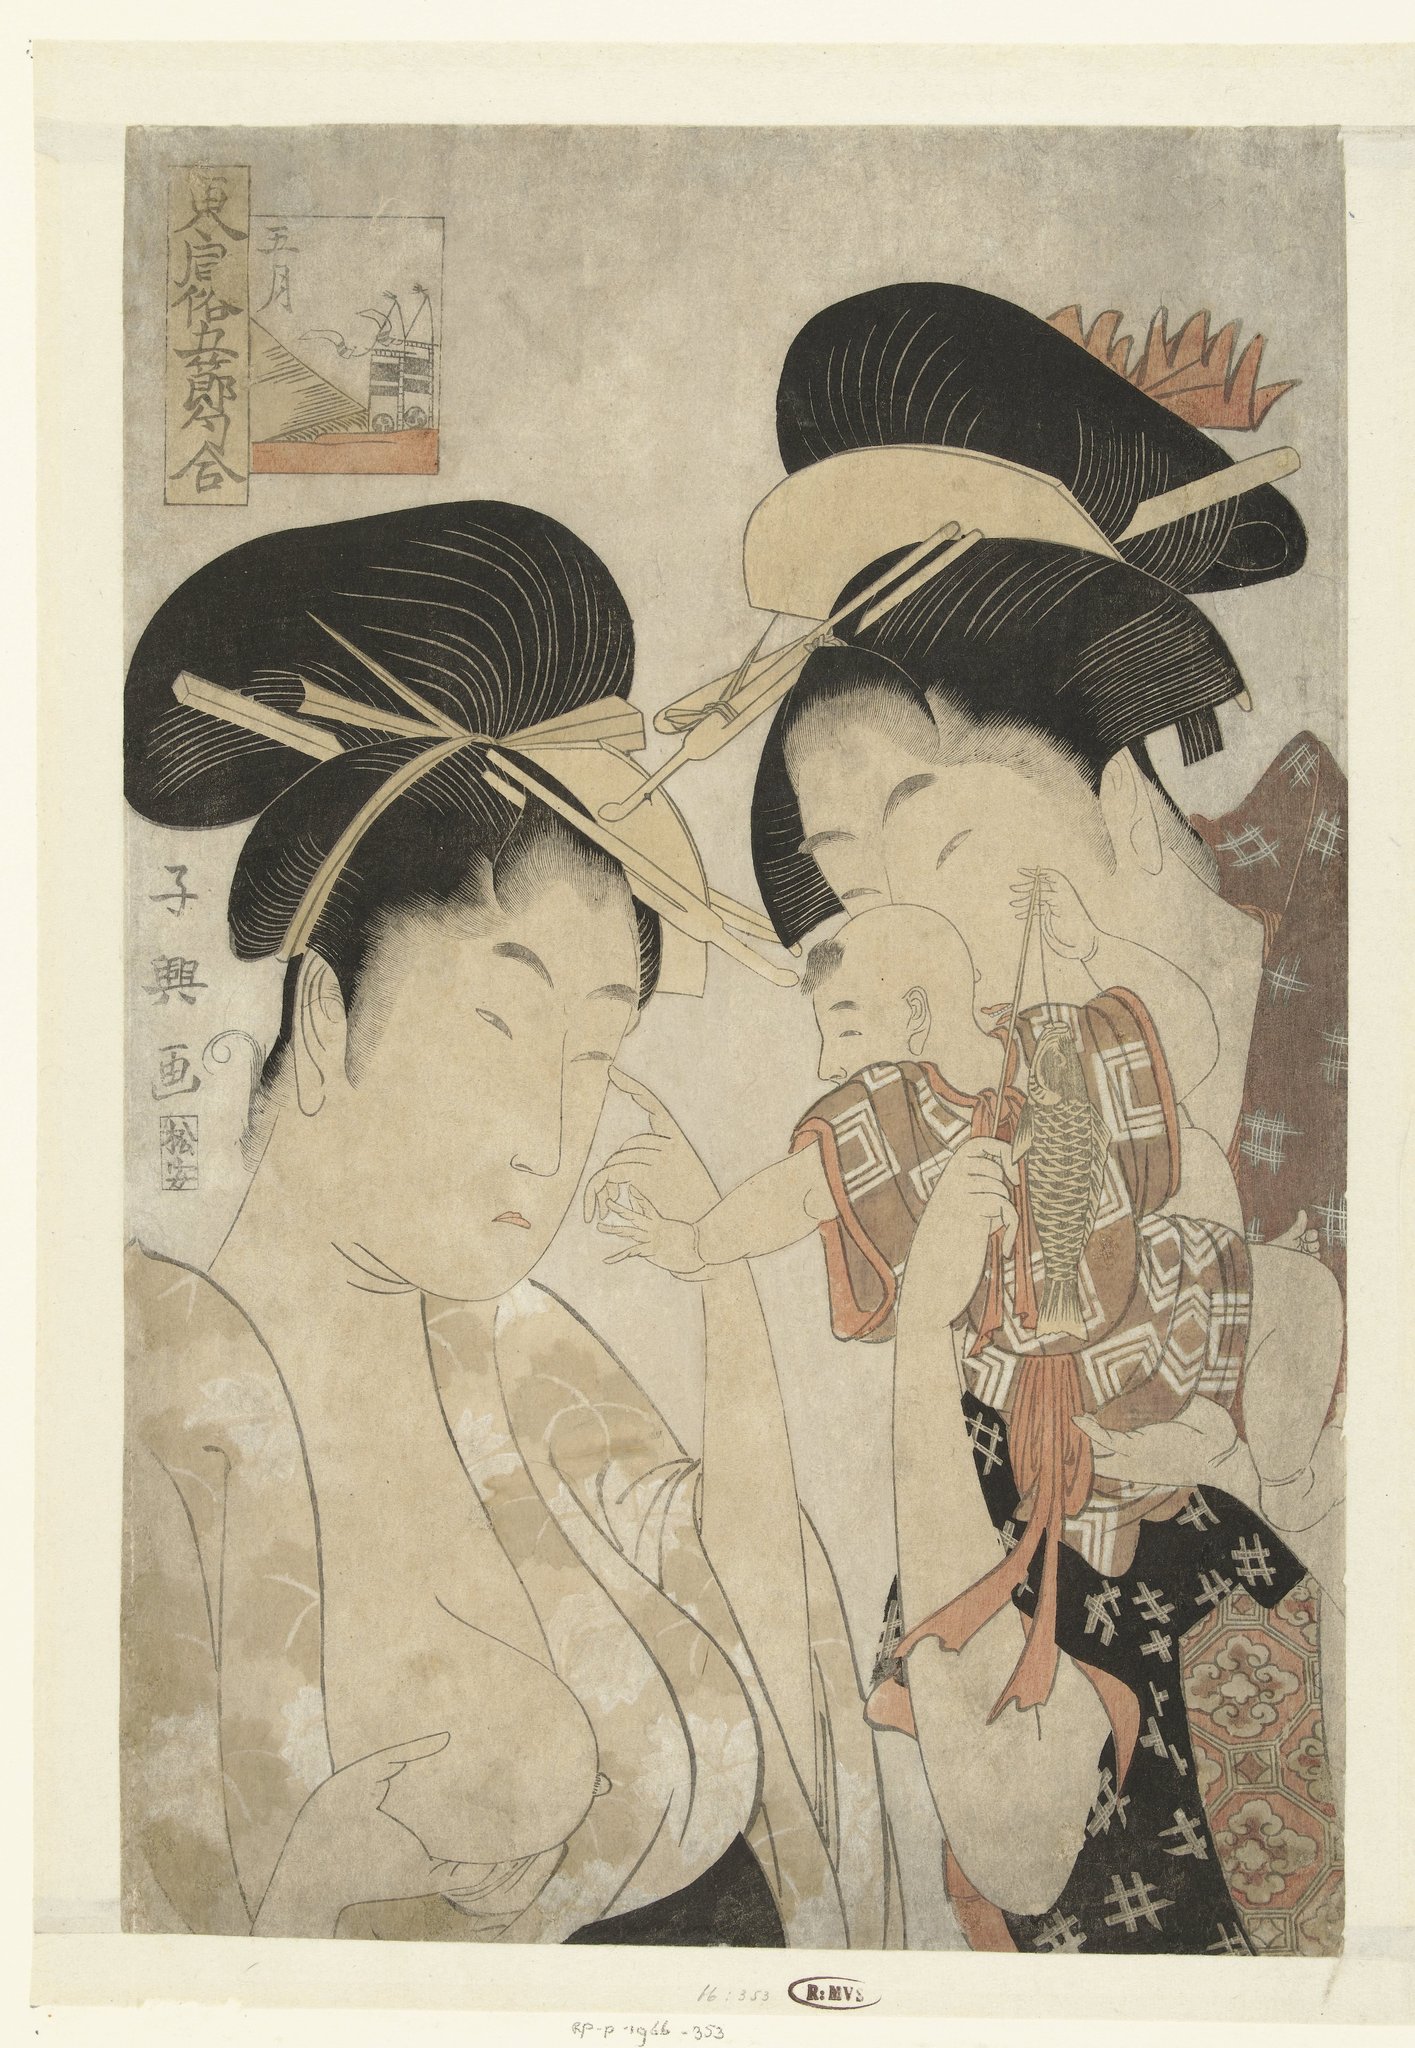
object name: print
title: Twee vrouwen en een klein kind: de vijfde maand.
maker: momokawa chôki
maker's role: print maker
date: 1800-1809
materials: paper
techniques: woodcut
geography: japan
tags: partially clothed, feeding a baby, adult woman (+ front view)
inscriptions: collector's mark: Lugt 2228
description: Vrouw, de borst aanbiedend aan klein kind, vastgehouden door tweede vrouw met in rechter hand een speelgoed hengel en karper. In vierkant cartouche linksboven een gezicht op wapperende banieren boven het dak van een huis. De banieren en de karper, symbool voor kracht en doorzettingsvermogen, verwijzen naar het 'Jongensfeest', gehouden op de vijfde dag van de vijfde maand.